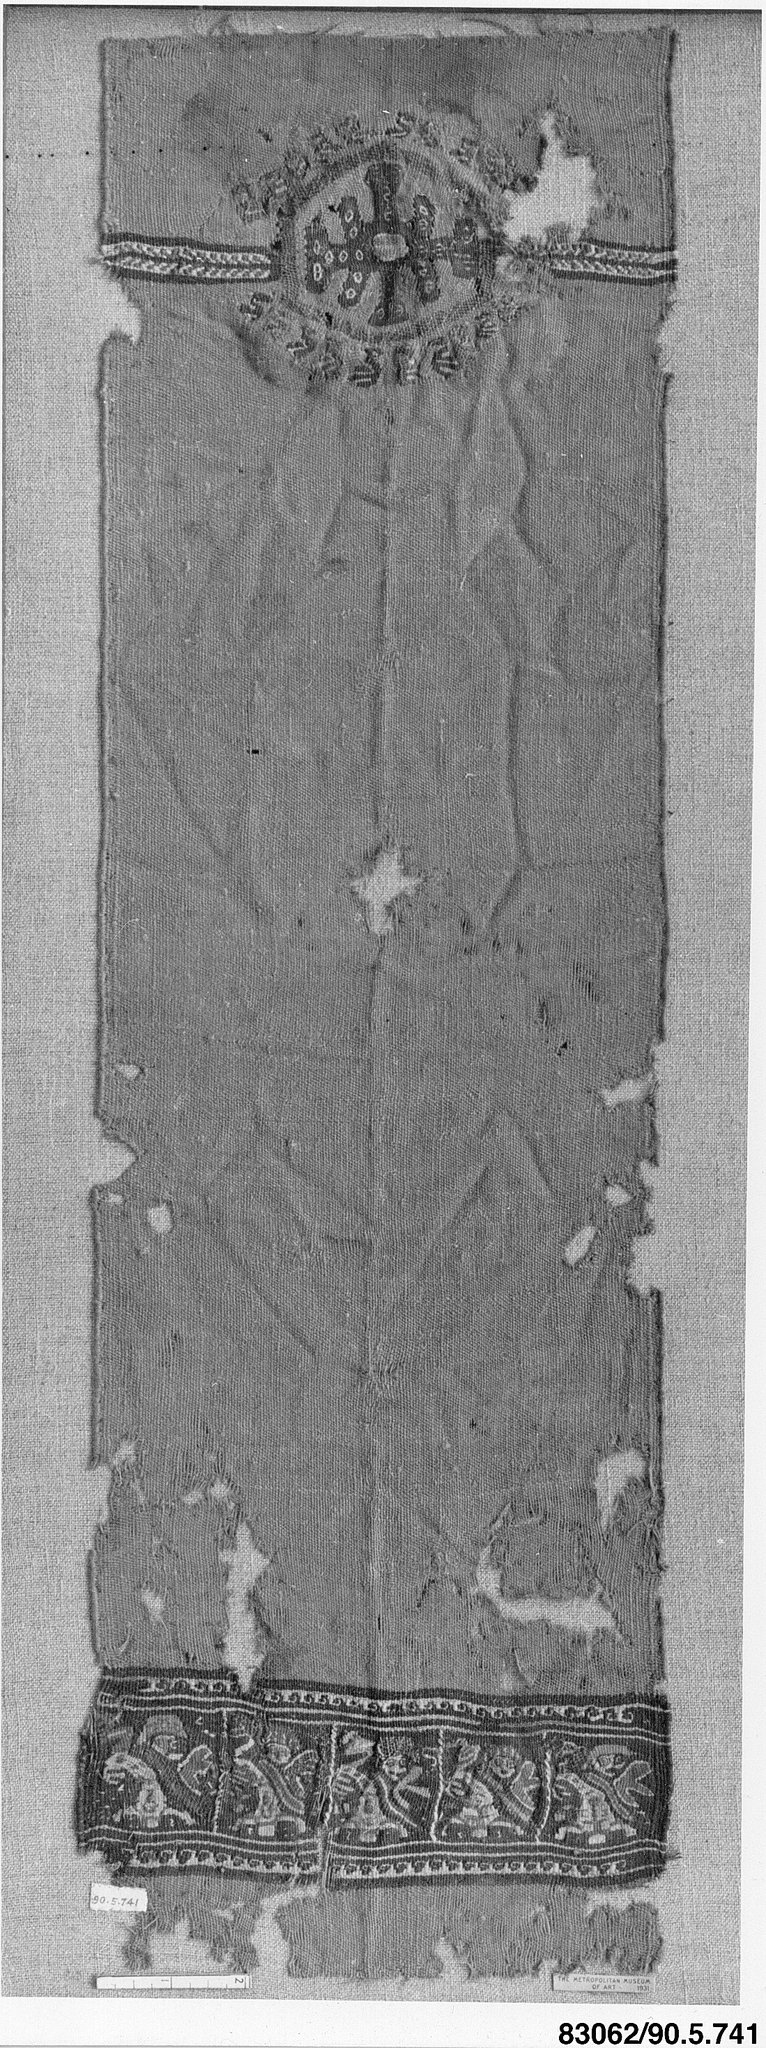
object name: textile fragment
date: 401-500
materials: linen, wool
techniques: weave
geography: egypt